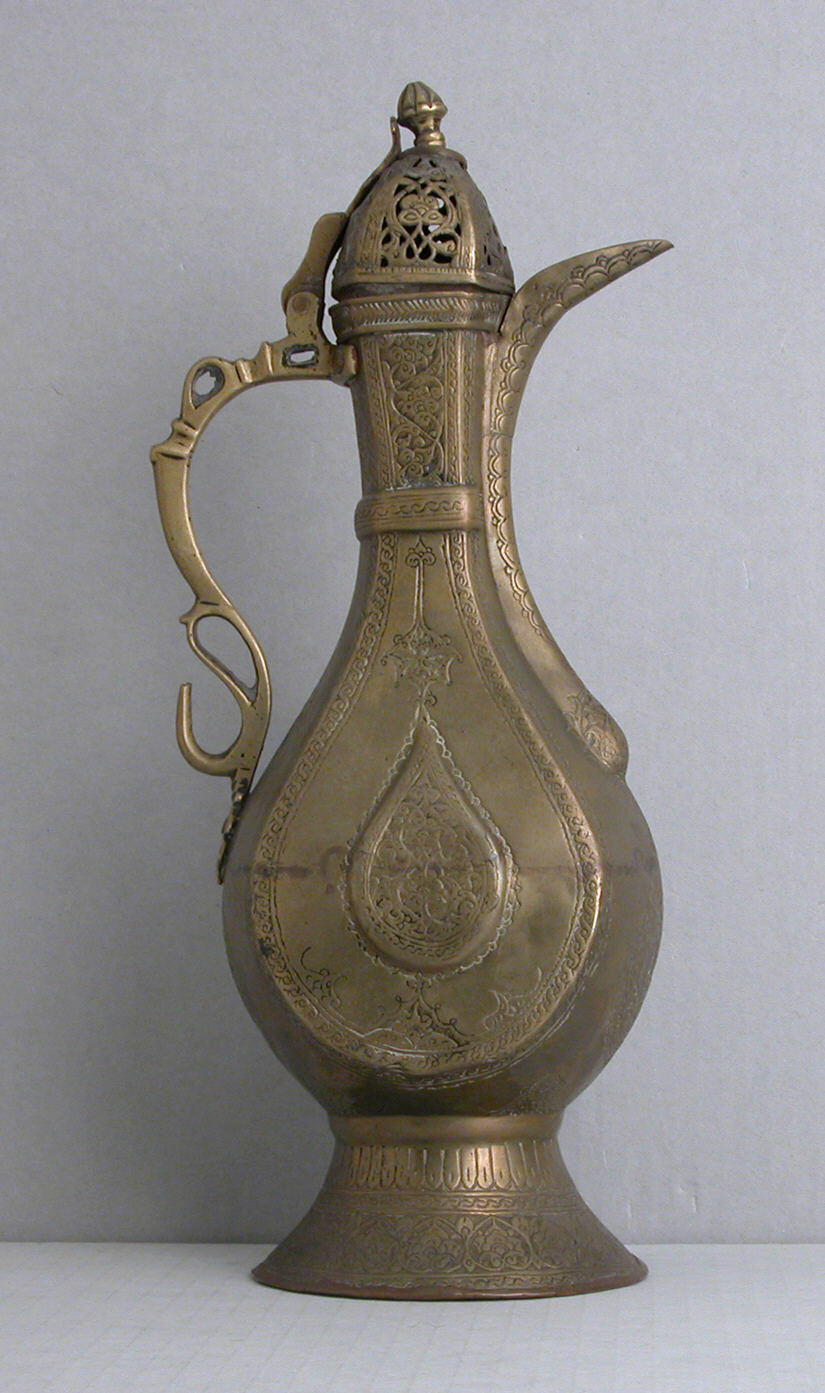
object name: ewer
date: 1801-1900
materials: brass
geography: probably central asia